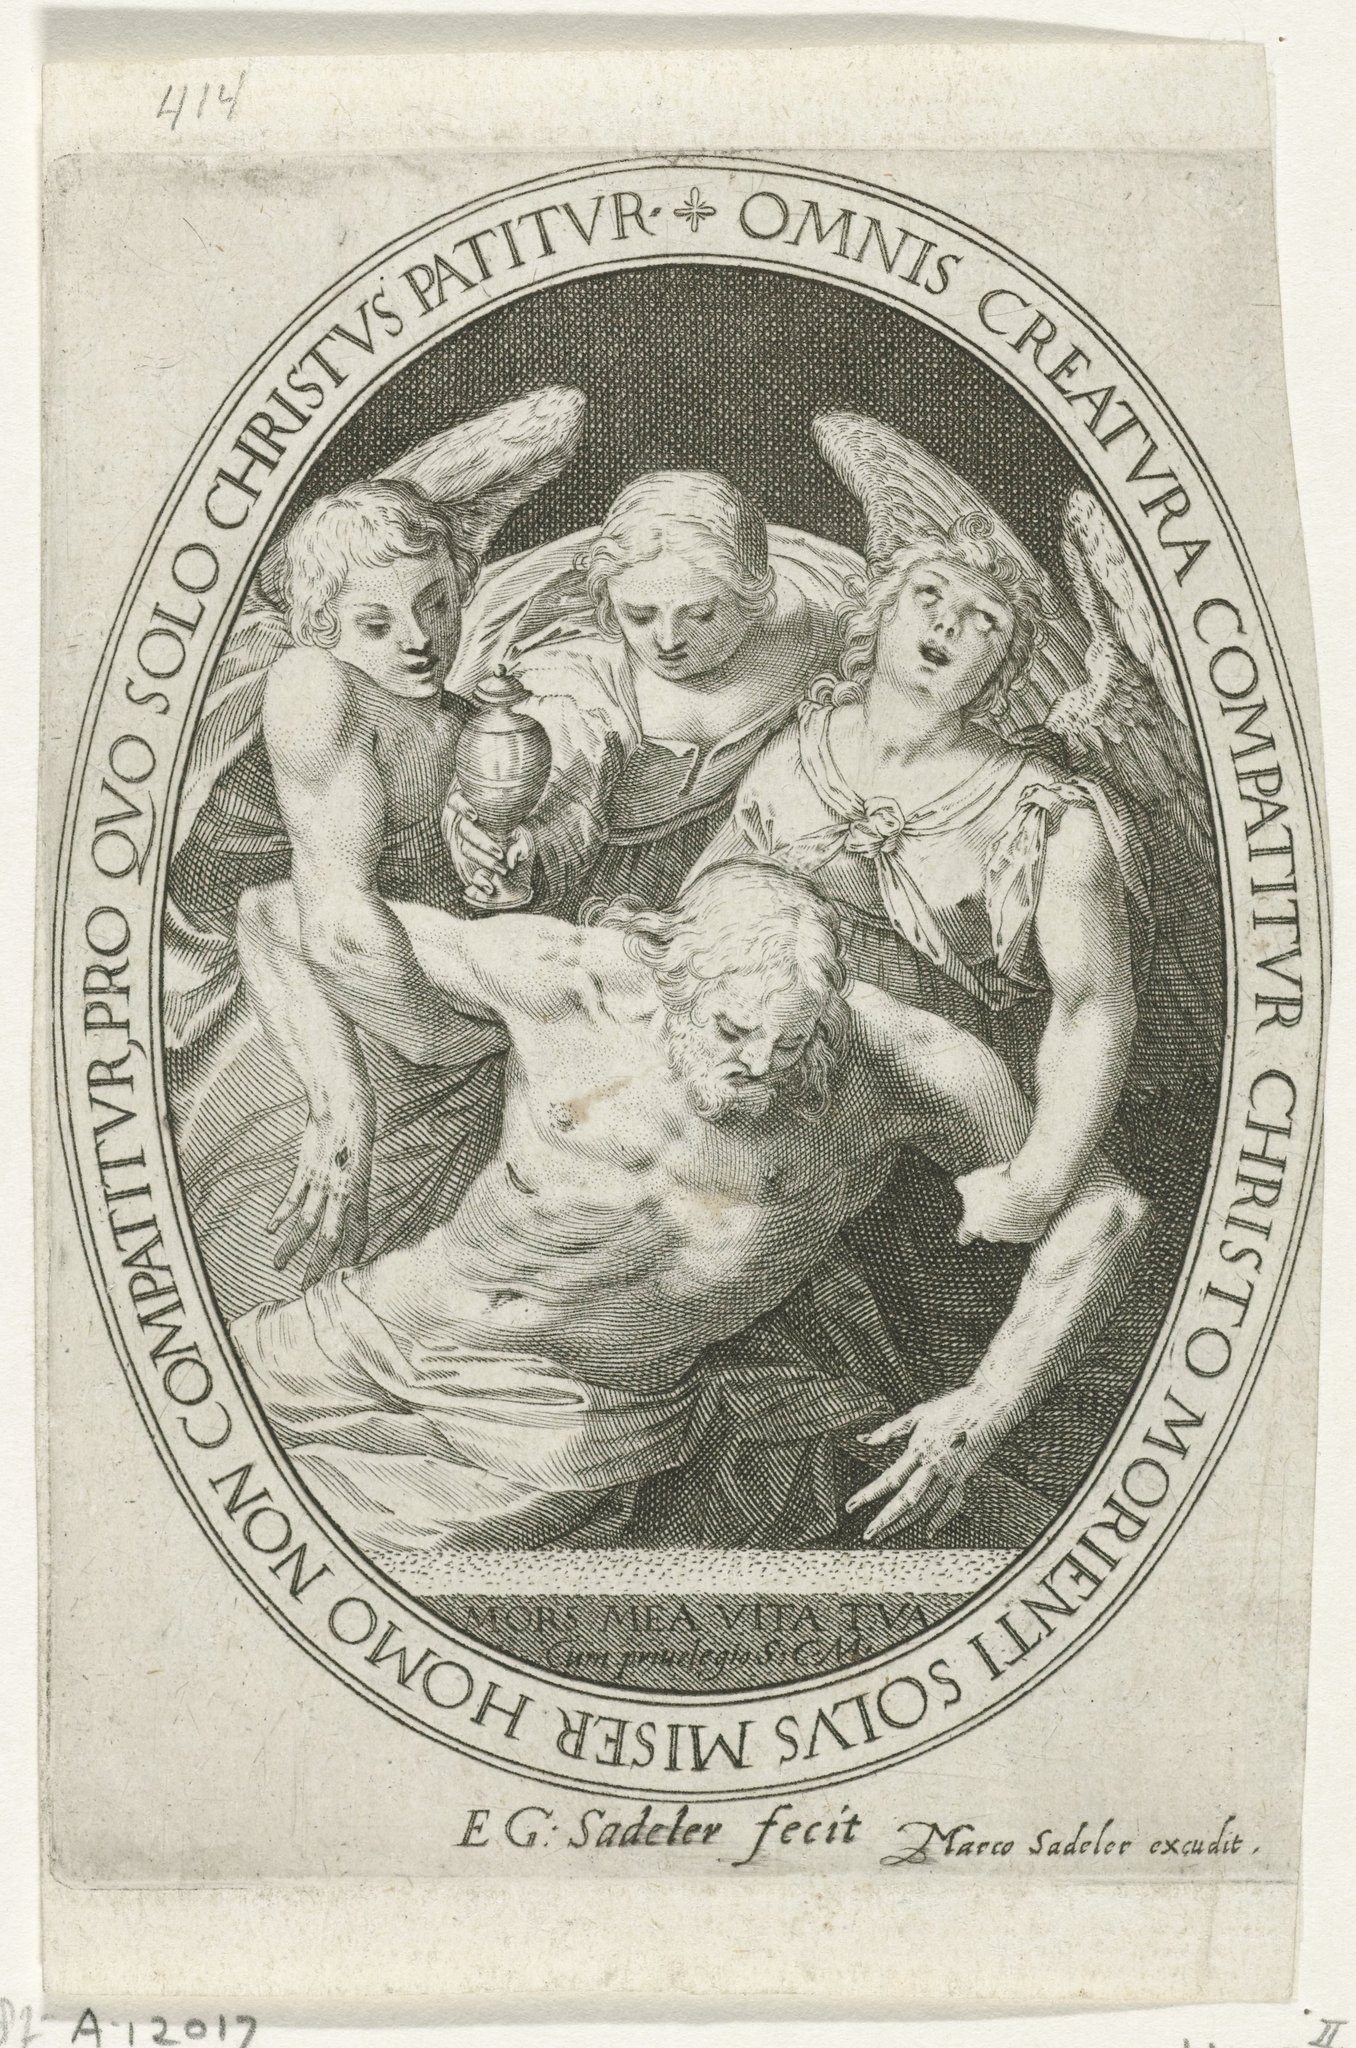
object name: print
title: Graflegging van Christus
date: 1580-1629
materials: paper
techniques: engraving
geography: venice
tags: christ's entombment (possibly by angels) (+ angel(s))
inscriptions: collector's mark: Lugt 2228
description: Het lichaam van Christus wordt door twee engelen ondersteund. In het midden Maria Magdalena met een urn met heilige olieën.